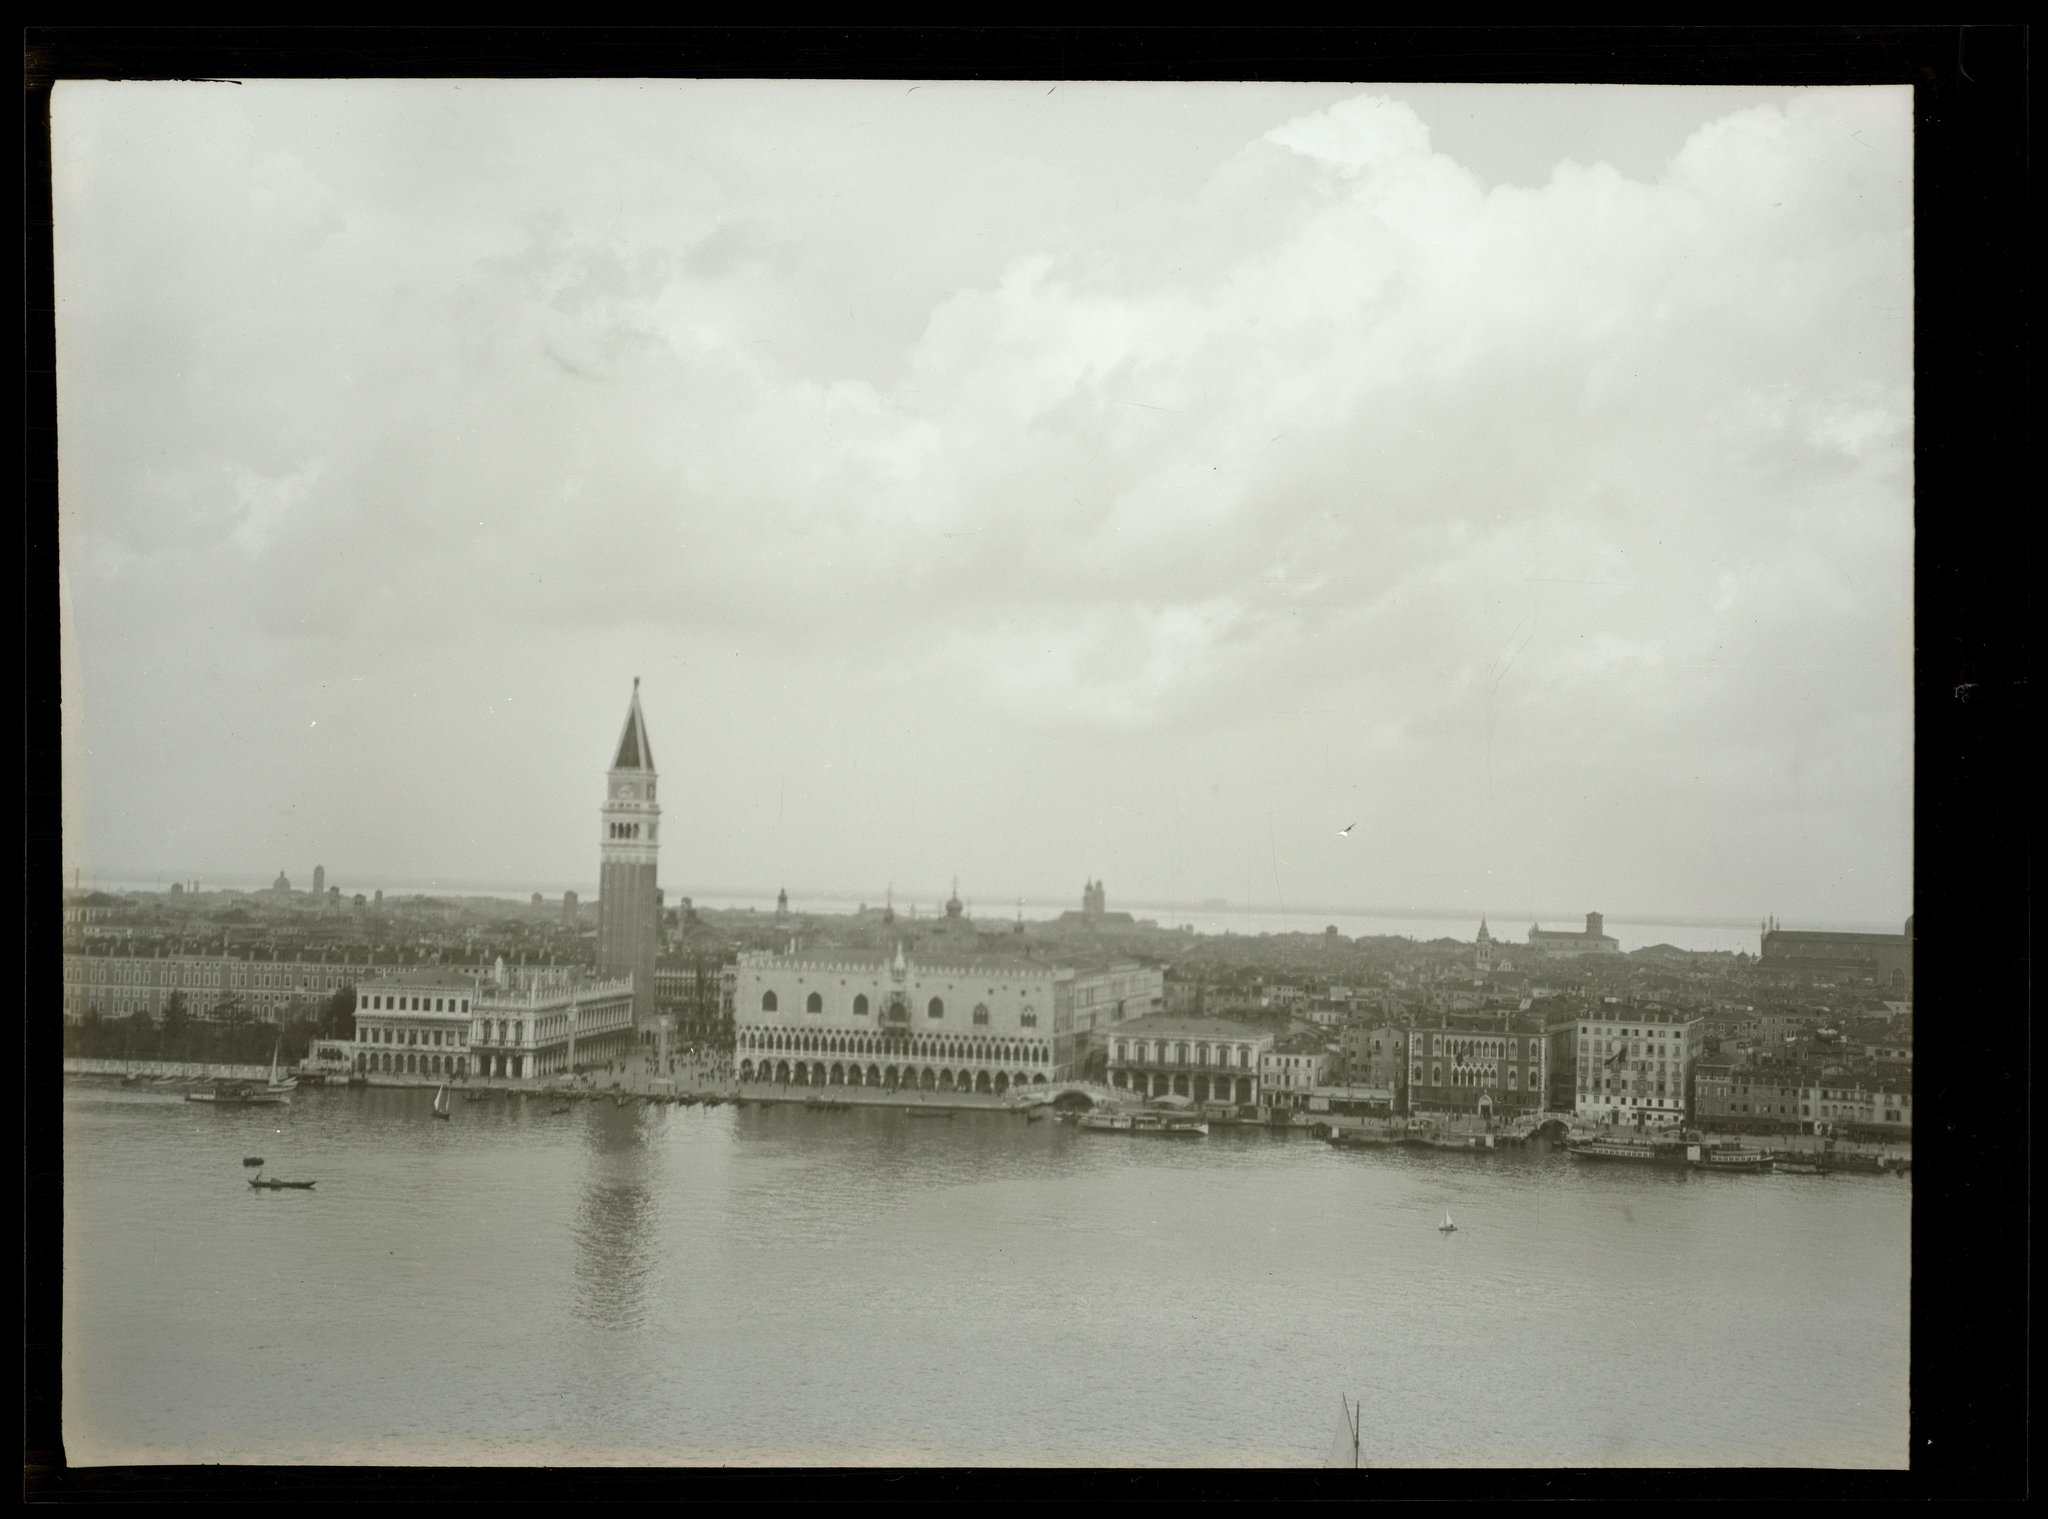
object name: photograph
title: Filmnegatief met opname van Venetië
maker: Anonymous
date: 1907-1935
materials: film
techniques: gelatin silver negative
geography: venice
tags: venice